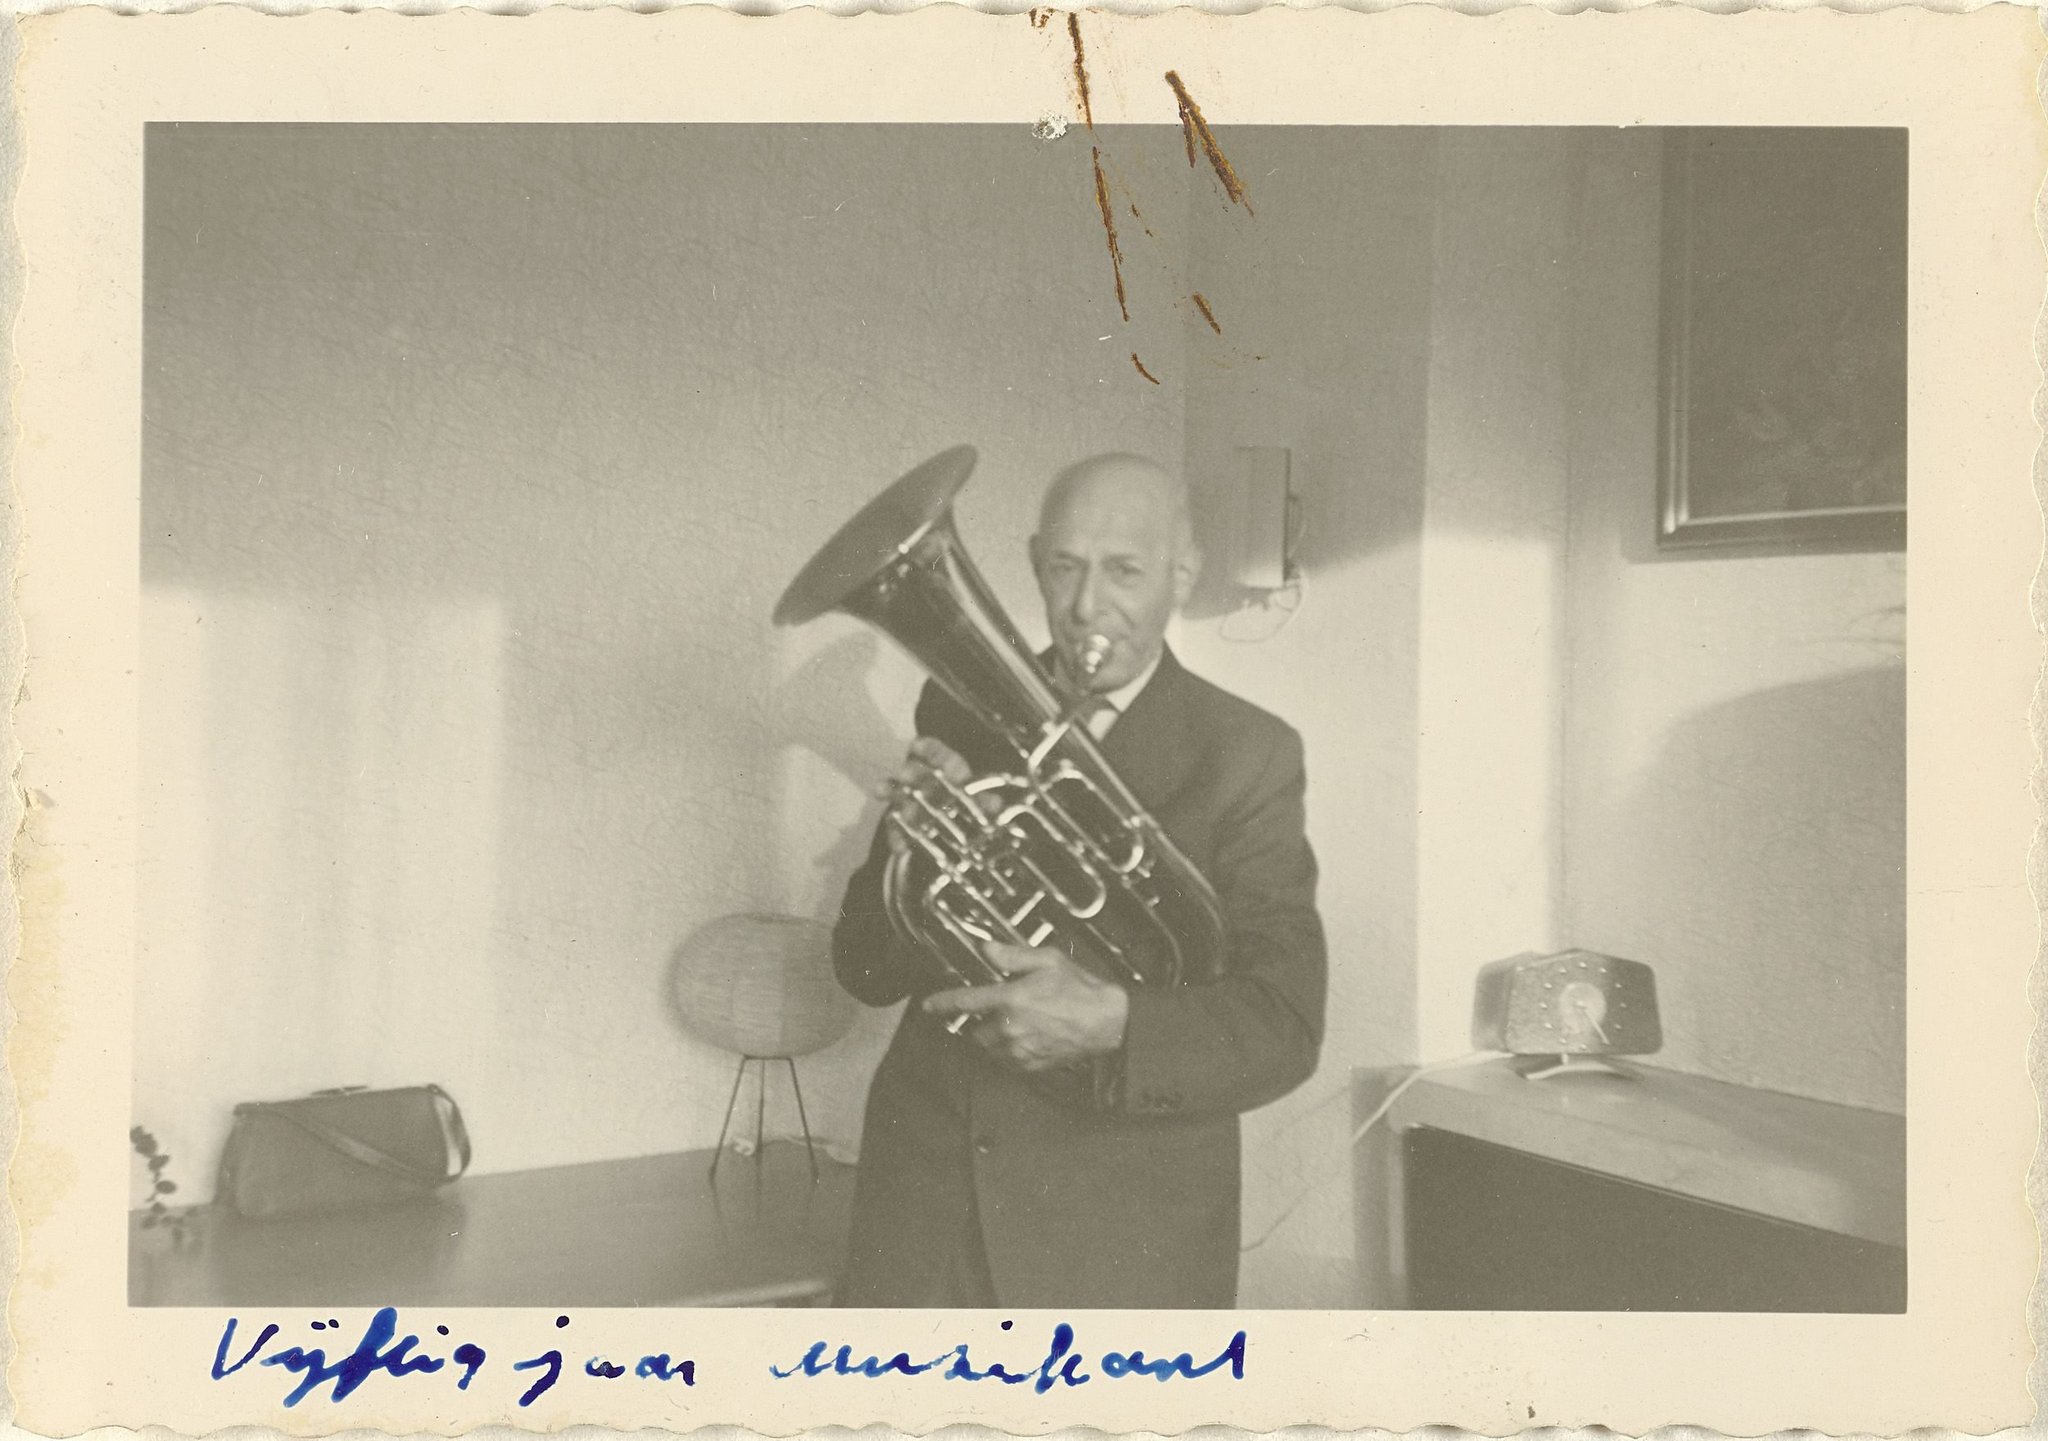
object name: photograph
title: Vijftig jaar muzikant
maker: Anonymous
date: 1930-1940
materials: photographic support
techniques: gelatin silver print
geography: netherlands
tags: horn, trumpet, cornet, trombone, tuba, portrait of a musician, historical persons not known by name